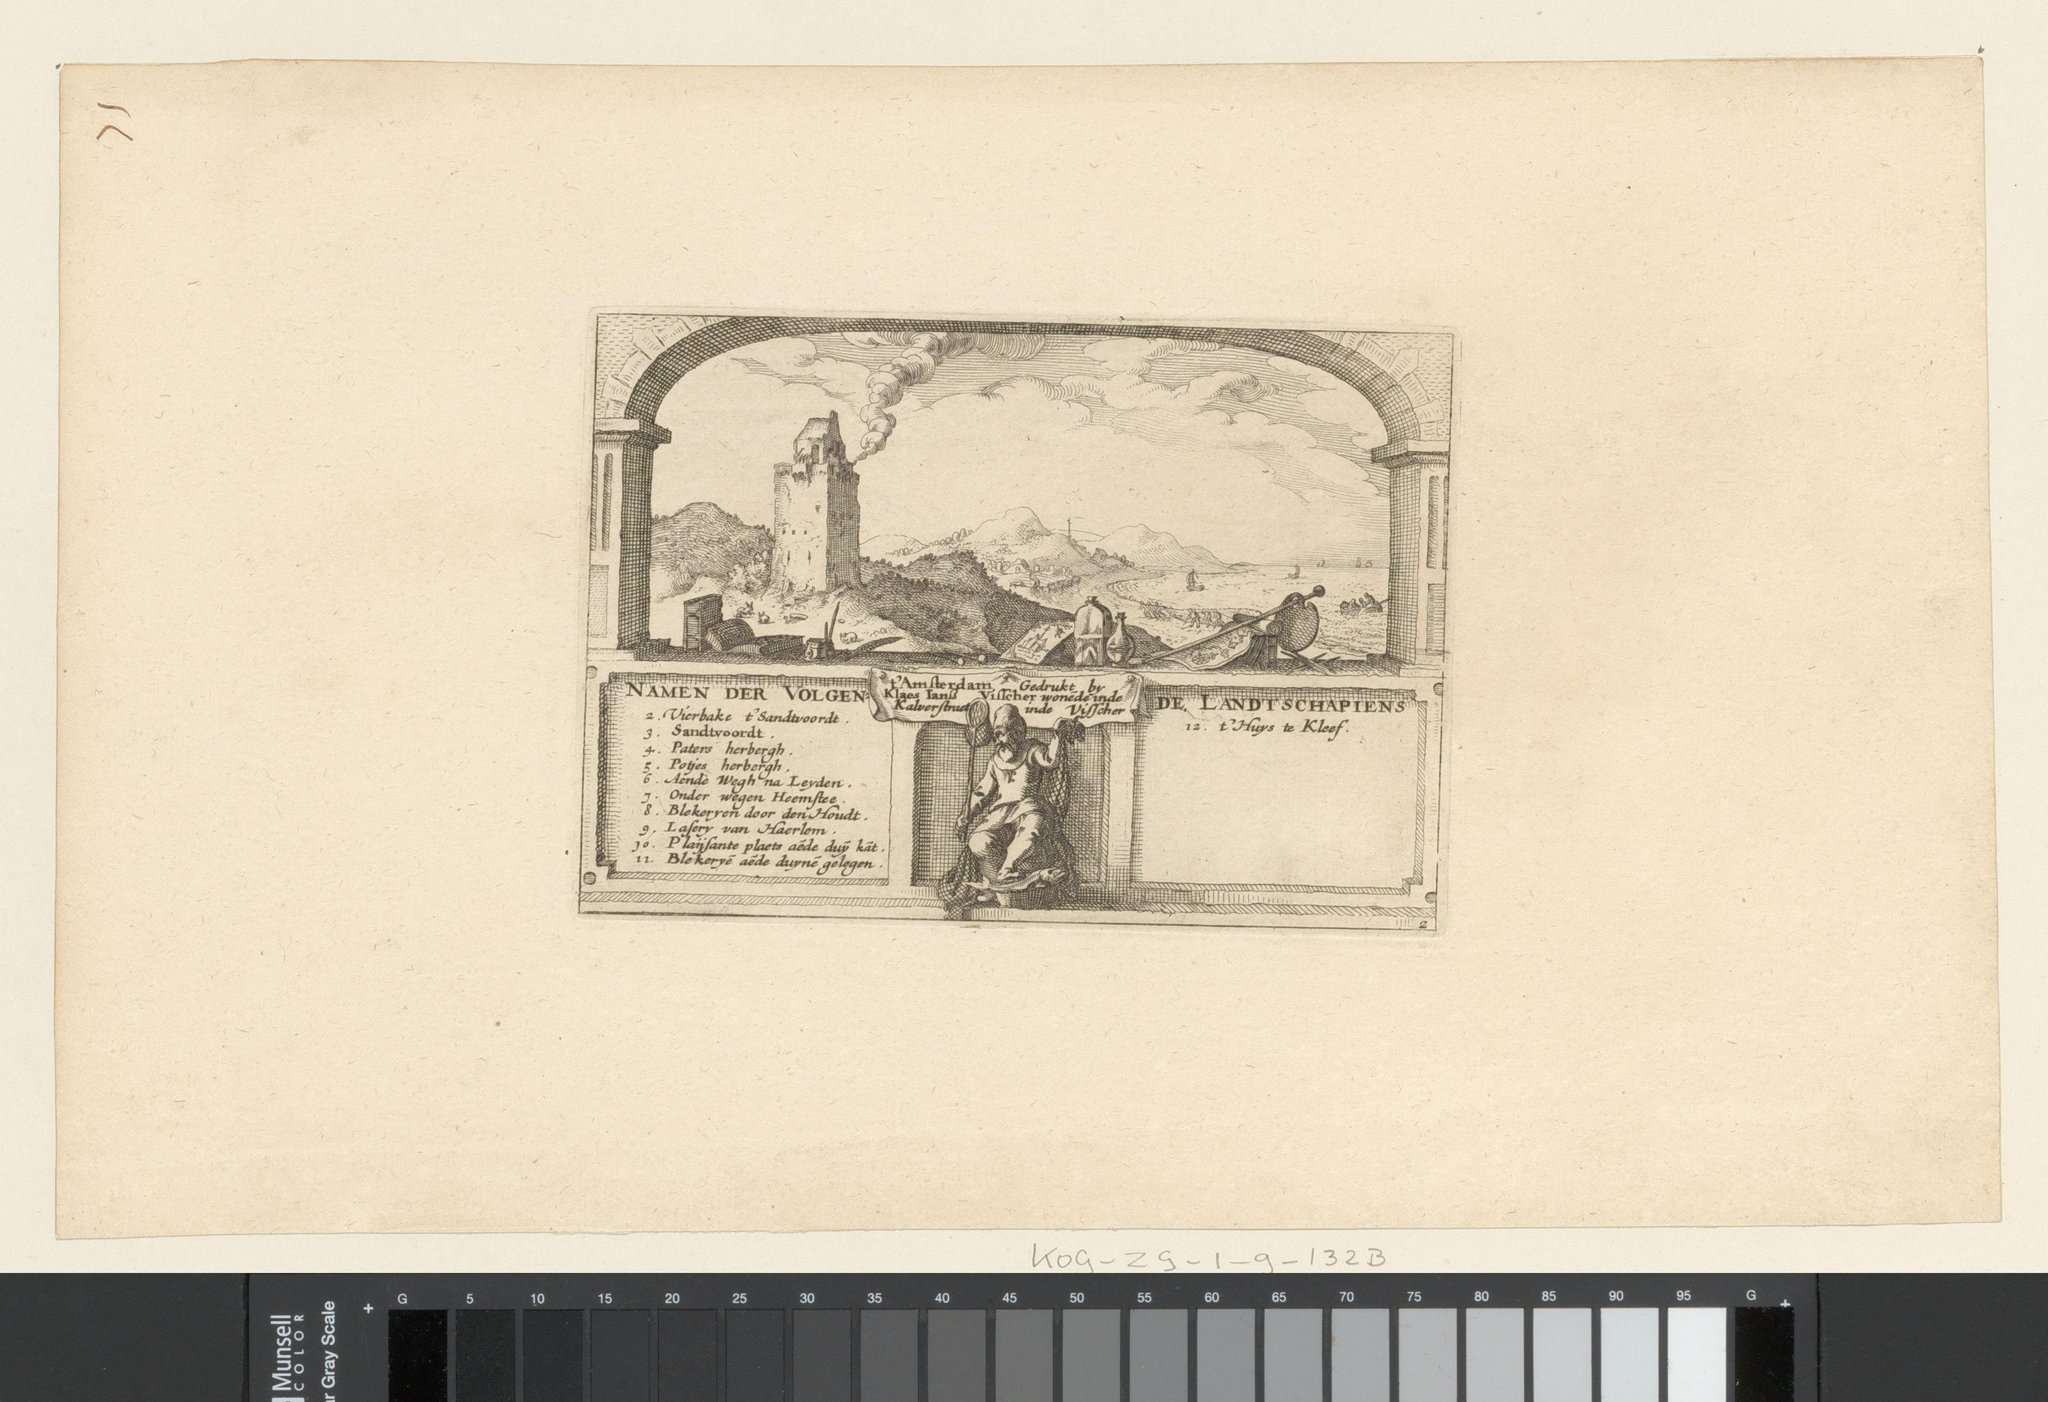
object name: titelprent, frontispice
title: Gezichten bij Haarlem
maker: claes jansz. visscher (ii)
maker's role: draughtsman, print maker, publisher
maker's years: 1586-1652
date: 1611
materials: paper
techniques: engraving, etching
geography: amsterdam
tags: lighthouse, lightship, beach, fisherman, rodents: rabbit, parts of church exterior and annexes: tower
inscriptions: stamp, collector's mark: Lugt 1641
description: Gezicht op de vuurtoren van Zandvoort, gevat in een boogvormig venster. Op de voorgrond boek- en drukkersattributen. Onder het tafereel twee kaders waartussen en visser zit. Links en rechts van de visser de nummers en namen van de topografische plaatsen die tot de serie 'Gezichten bij Haarlem' behoren. Onderwerpsrubrieken binnen de Atlas Zeden en Gewoonten: Handel, nijverheid en verkeer, Buitenleven.